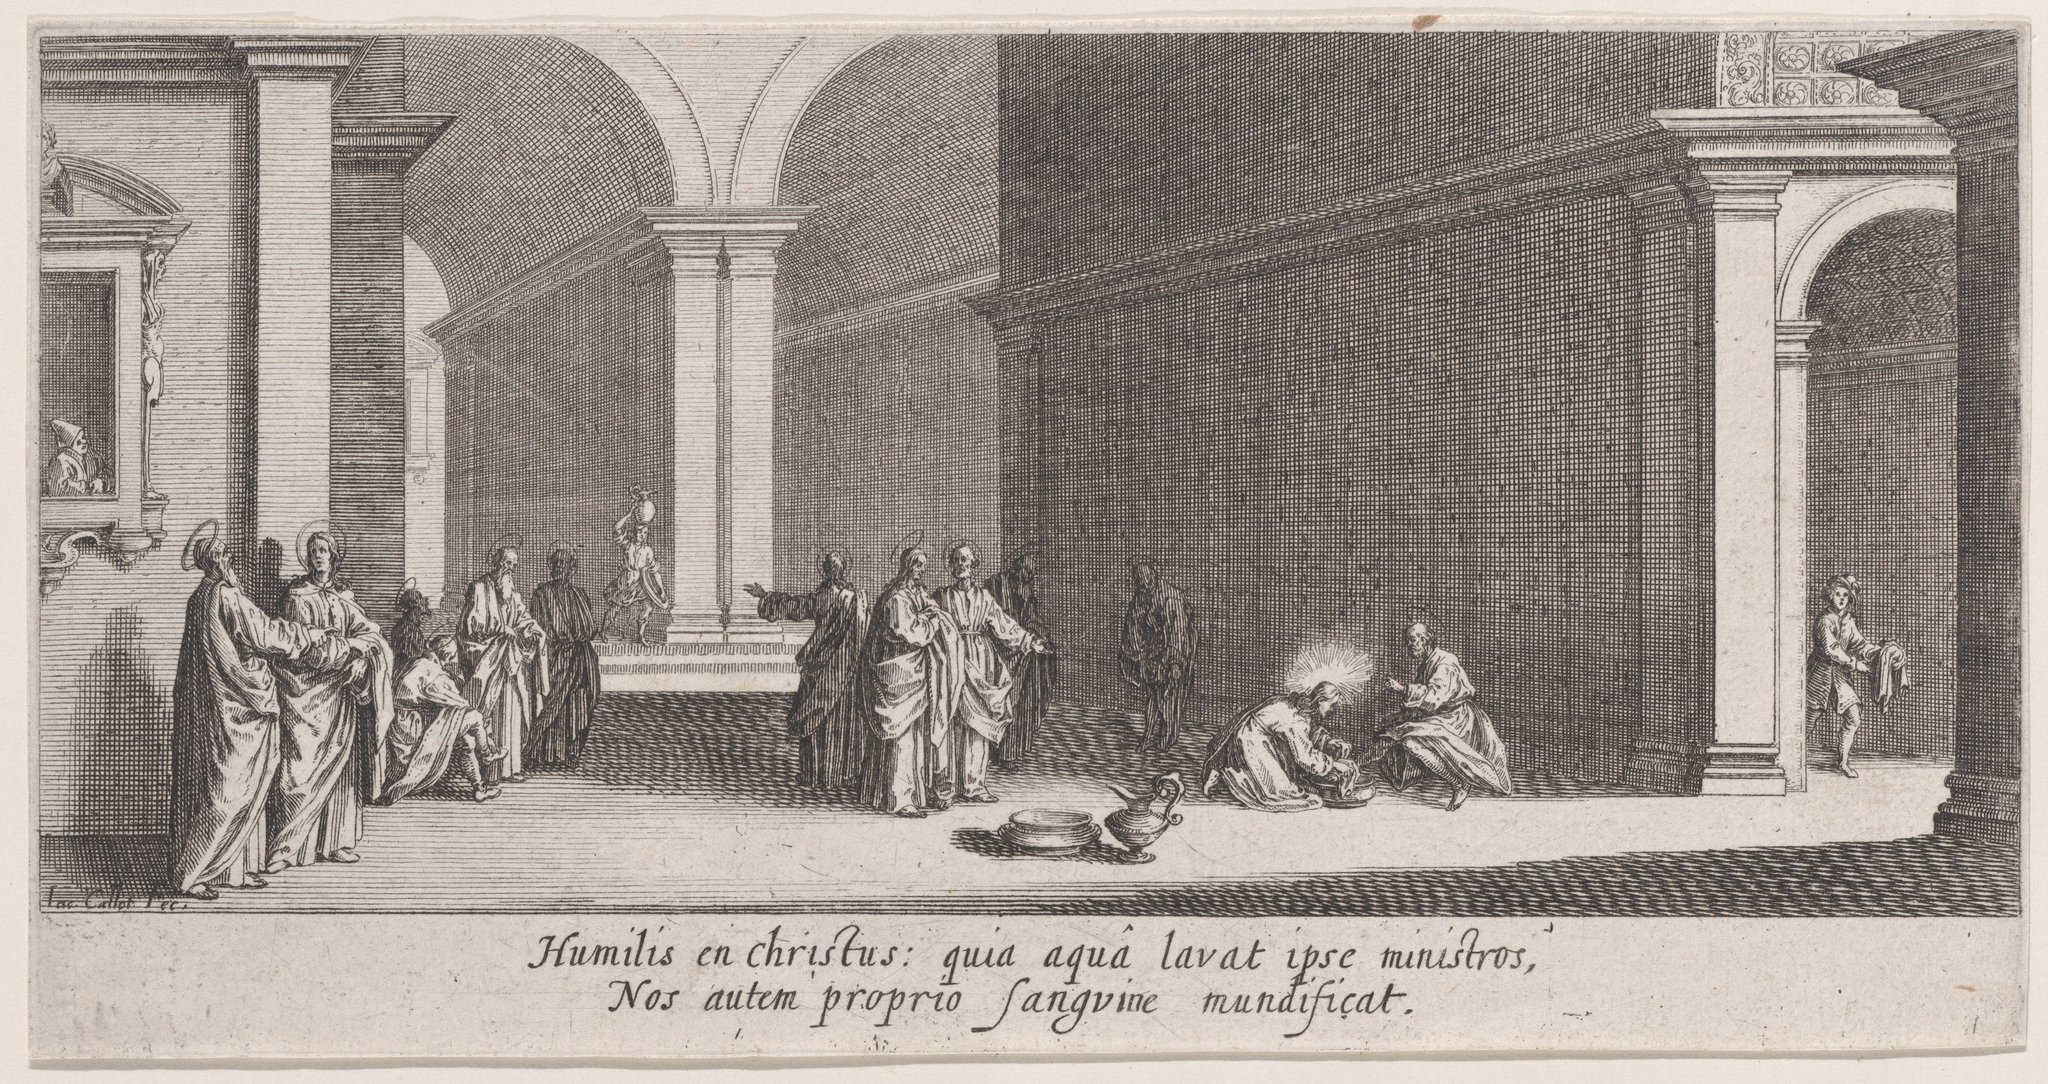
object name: print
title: Le Lavement des Pieds (The Washing of the Feet), from "La Grande Passion" (The Large Passion)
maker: jacques callot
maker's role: artist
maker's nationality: french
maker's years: 1592-1635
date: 1619-1624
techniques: engraving, etching